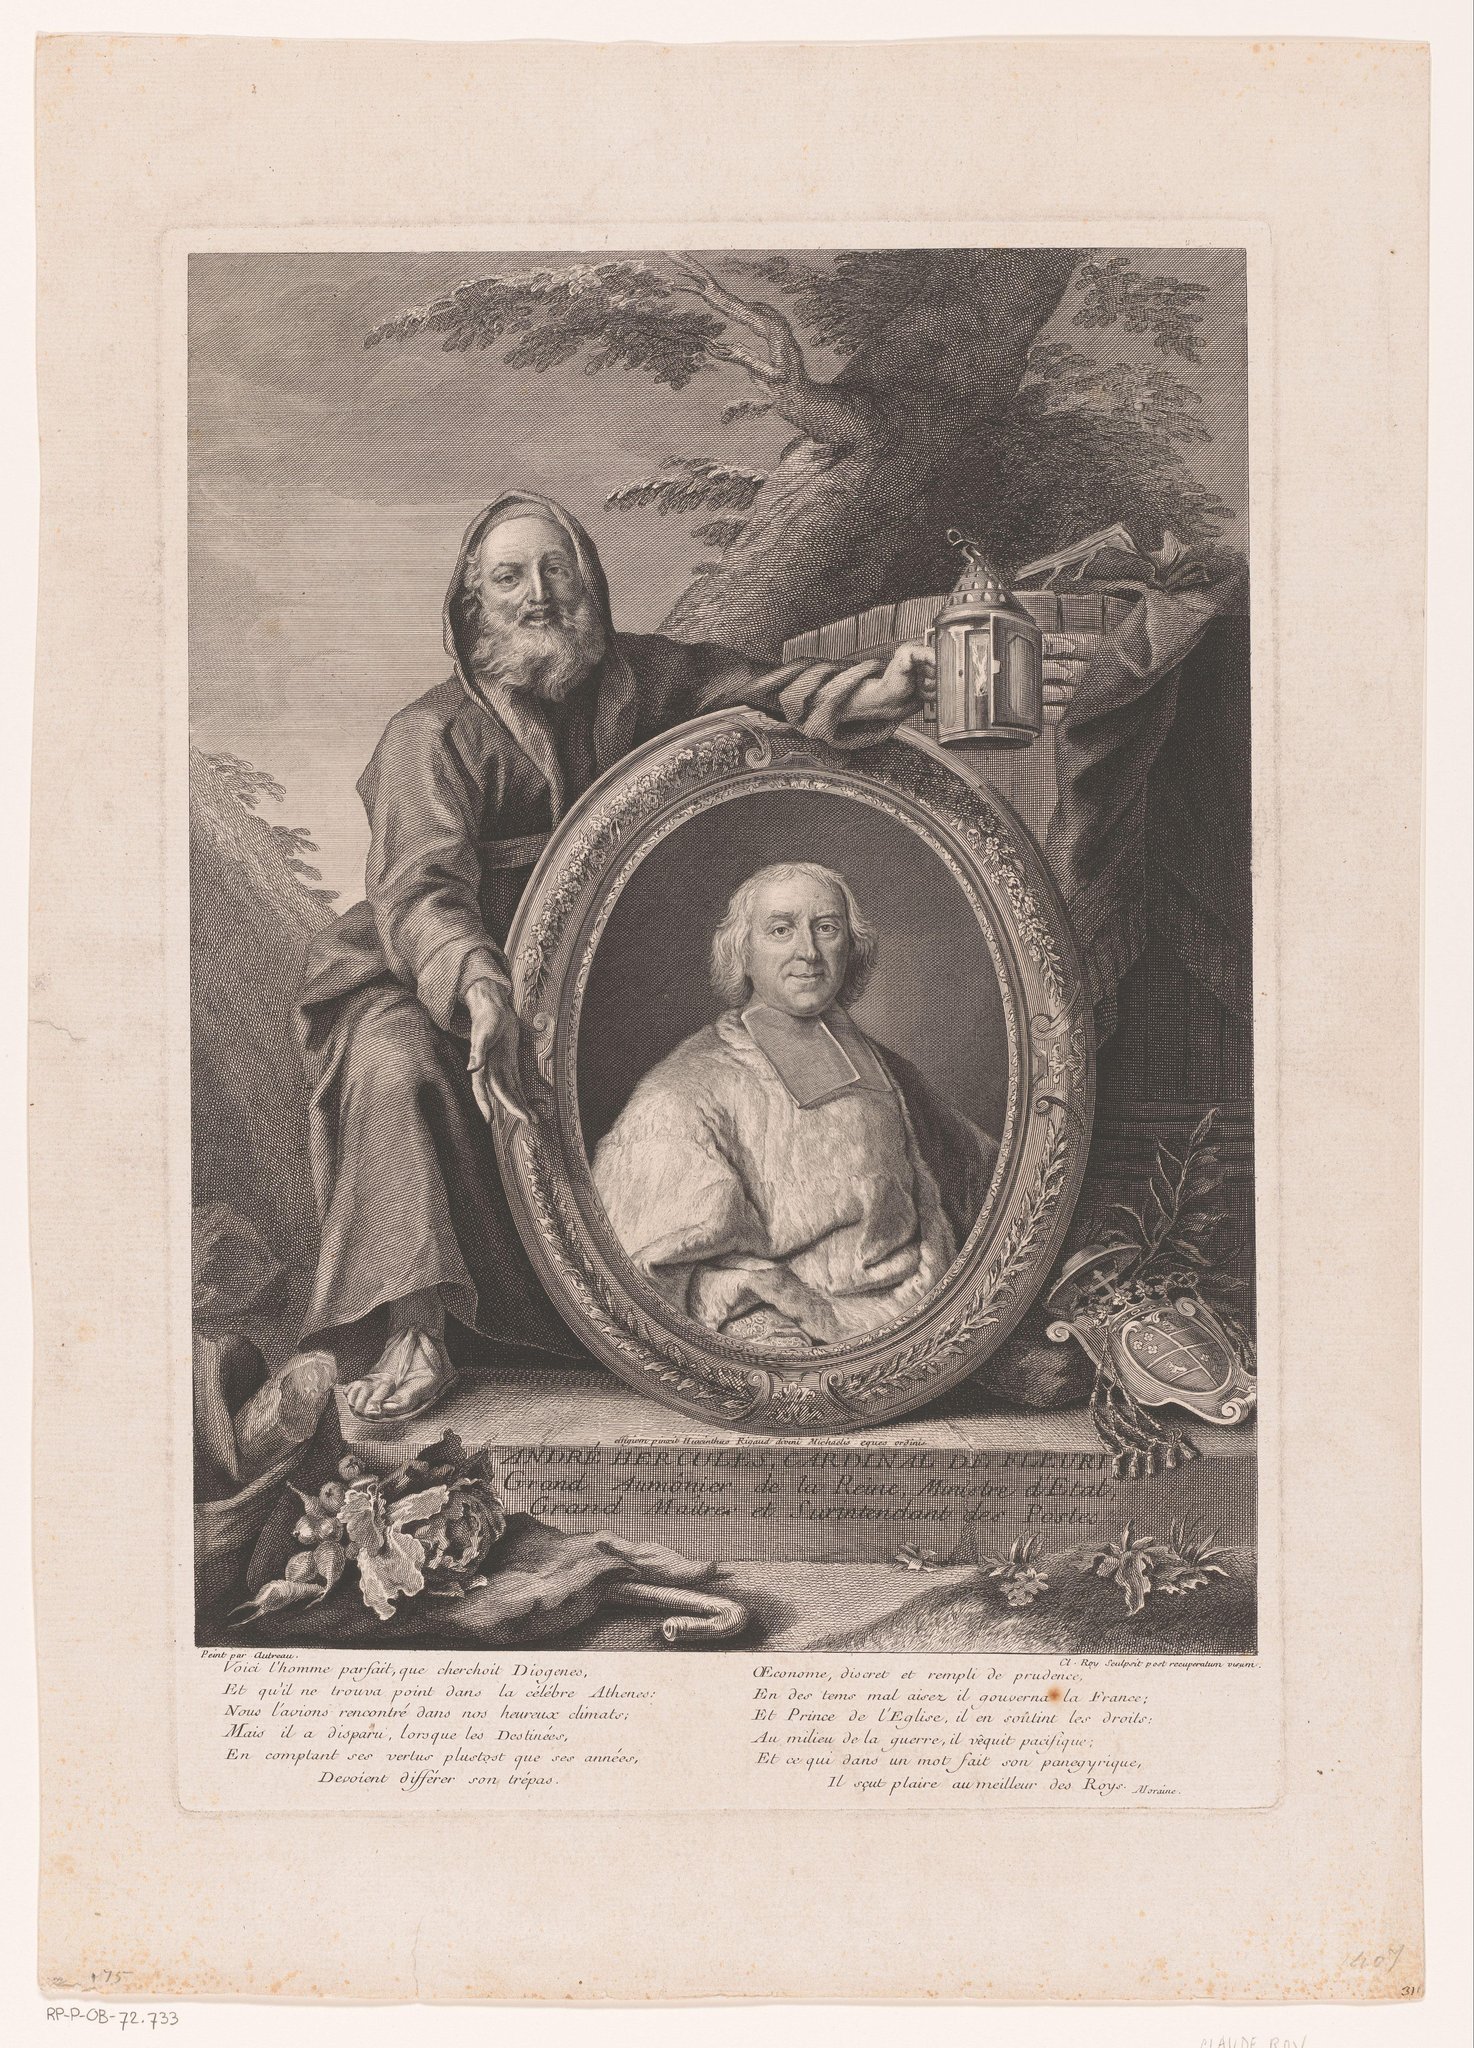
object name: print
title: Portret van André-Hercule de Fleury, getoond door Diogenes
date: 1717-1797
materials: paper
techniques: engraving, etching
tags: cardinal, historical persons, lantern, (story of) diogenes, the philosopher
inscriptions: collector's mark: Lugt 240